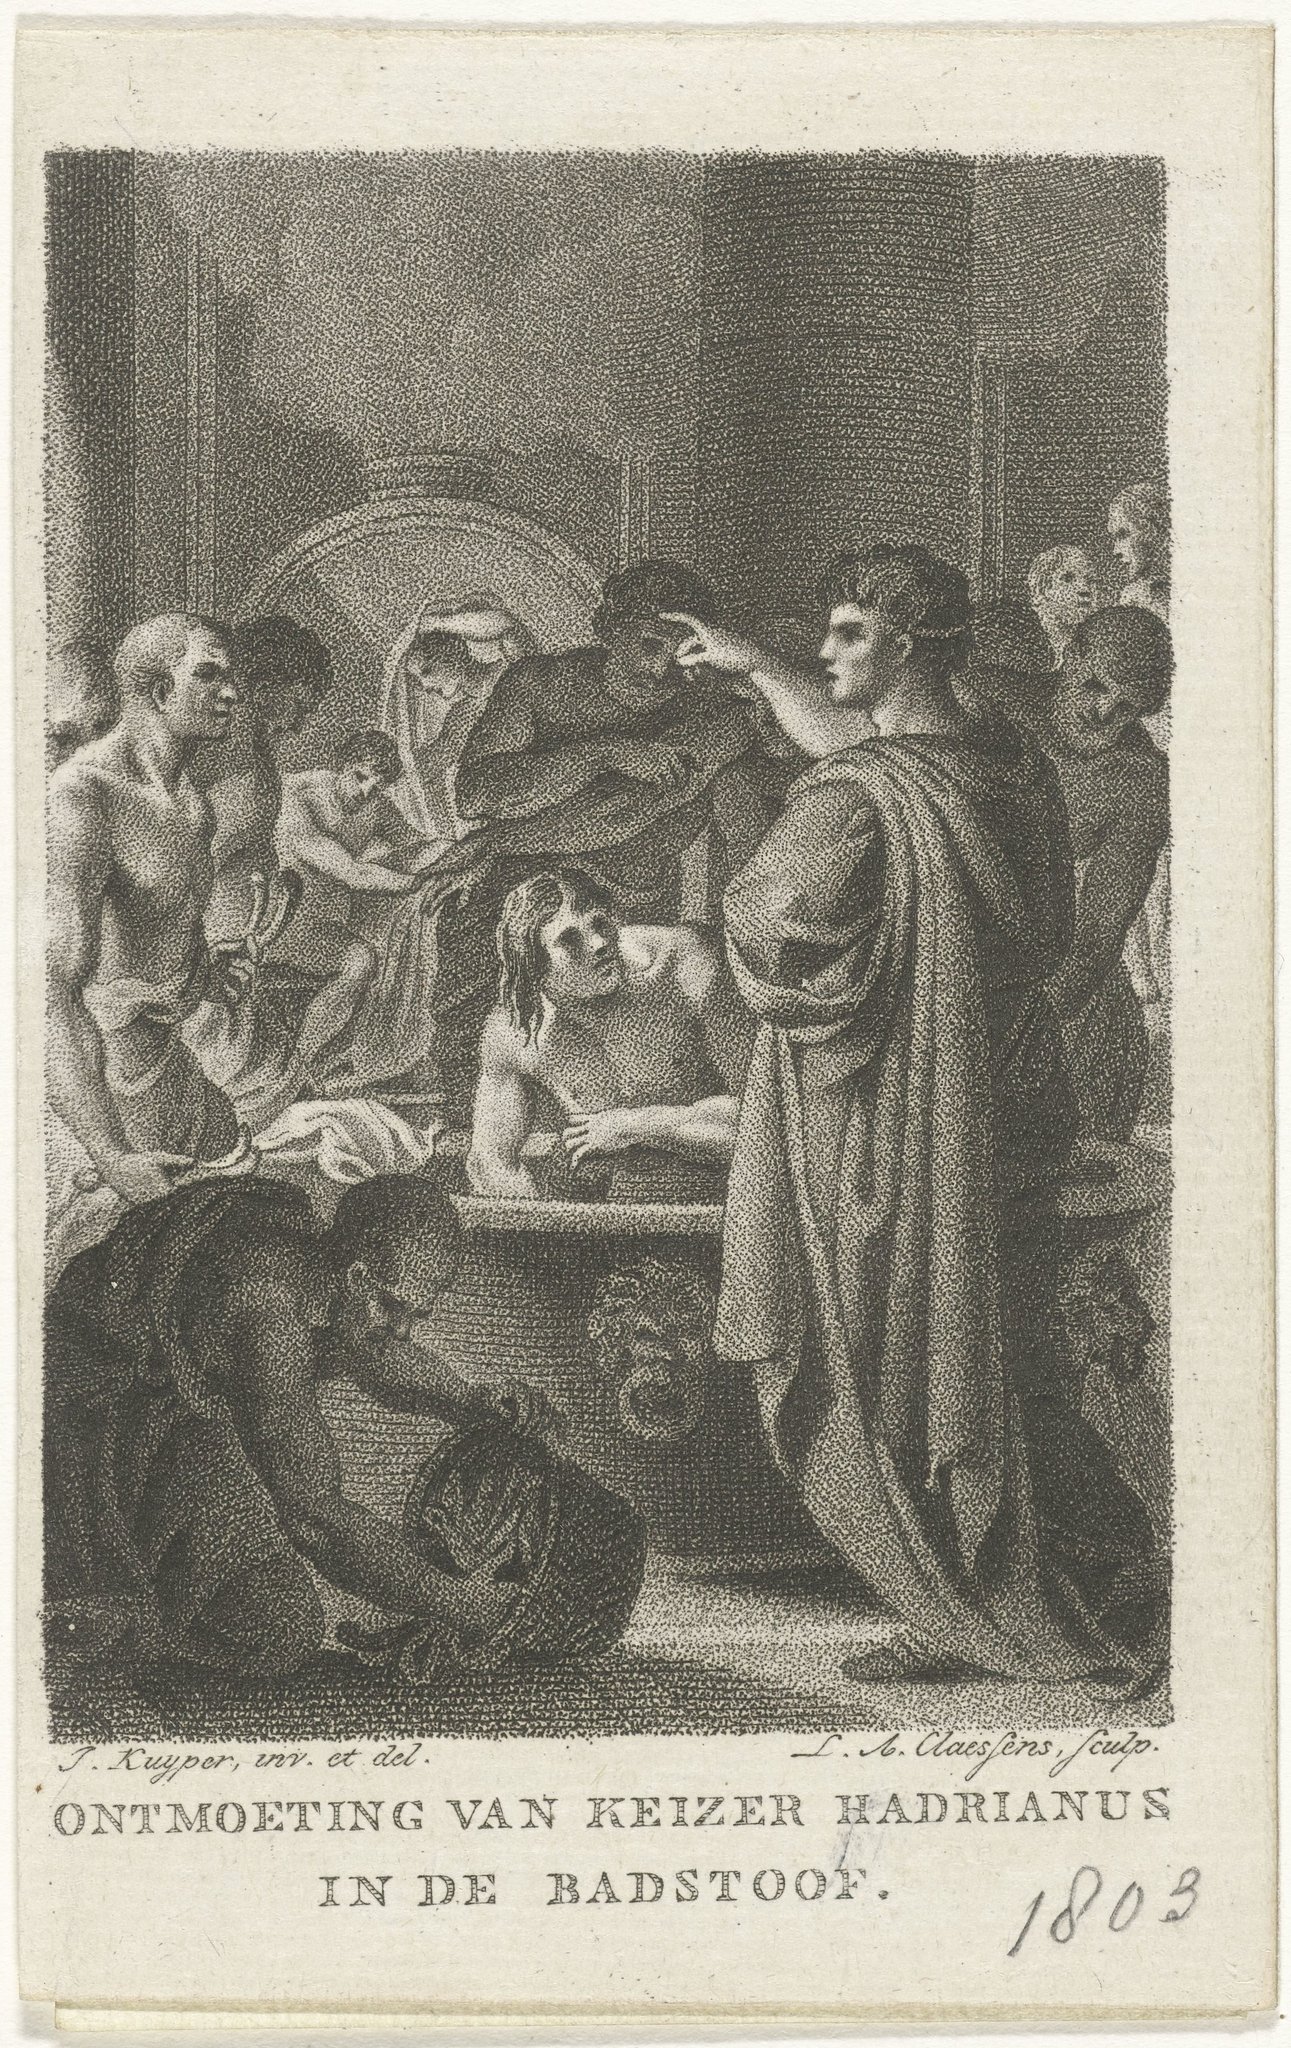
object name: print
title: Keizer Hadrianus in bad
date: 1803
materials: paper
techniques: etching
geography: amsterdam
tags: taking a bath, slavery; serfs and enslaved persons, bath-tub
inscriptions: collector's mark: Lugt 2228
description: Keizer Hadrianus neemt een bad. Tientallen tot slaaf gemaakte mannen verzorgen hem. Hadrianus ontmoet een oude soldaat die hem vertelt dat hij geen slaafgemaakten heeft om hem de rug te schrobben. Hij schrobt zelf met zijn rug tegen een steen om die schoon te krijgen. Hadrianus geeft de oude soldaat slaafgemaakten zodat hij niet meer zelf zijn rug hoeft te schrobben.